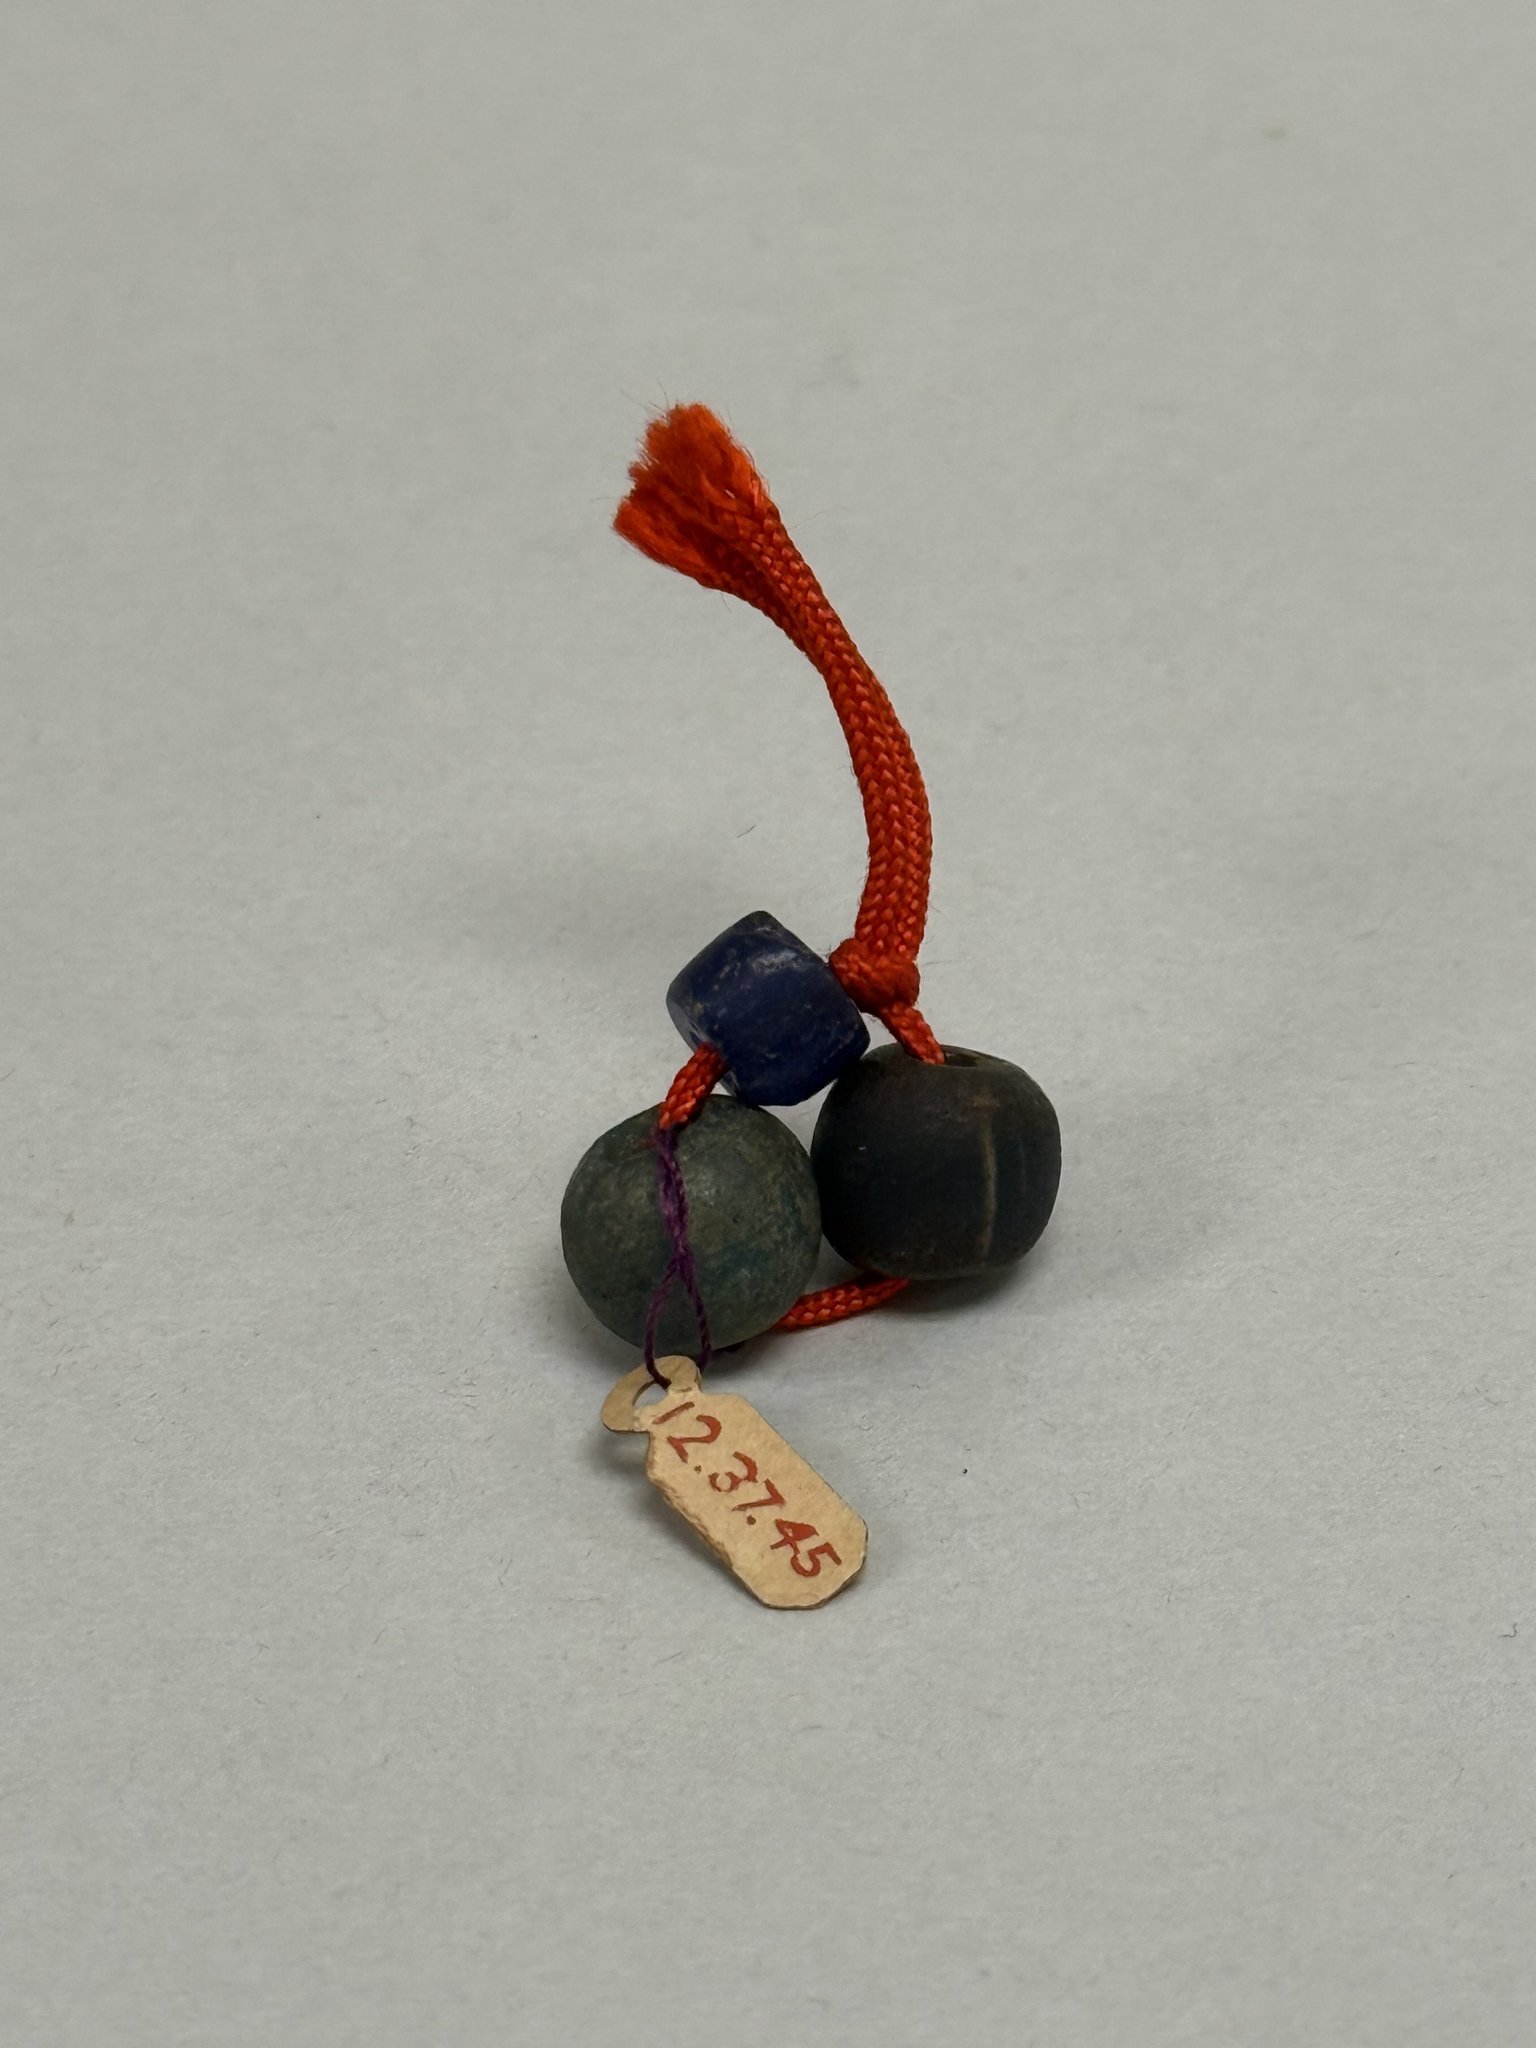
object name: bead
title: Beads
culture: japanese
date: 601-700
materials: glass, lacquer